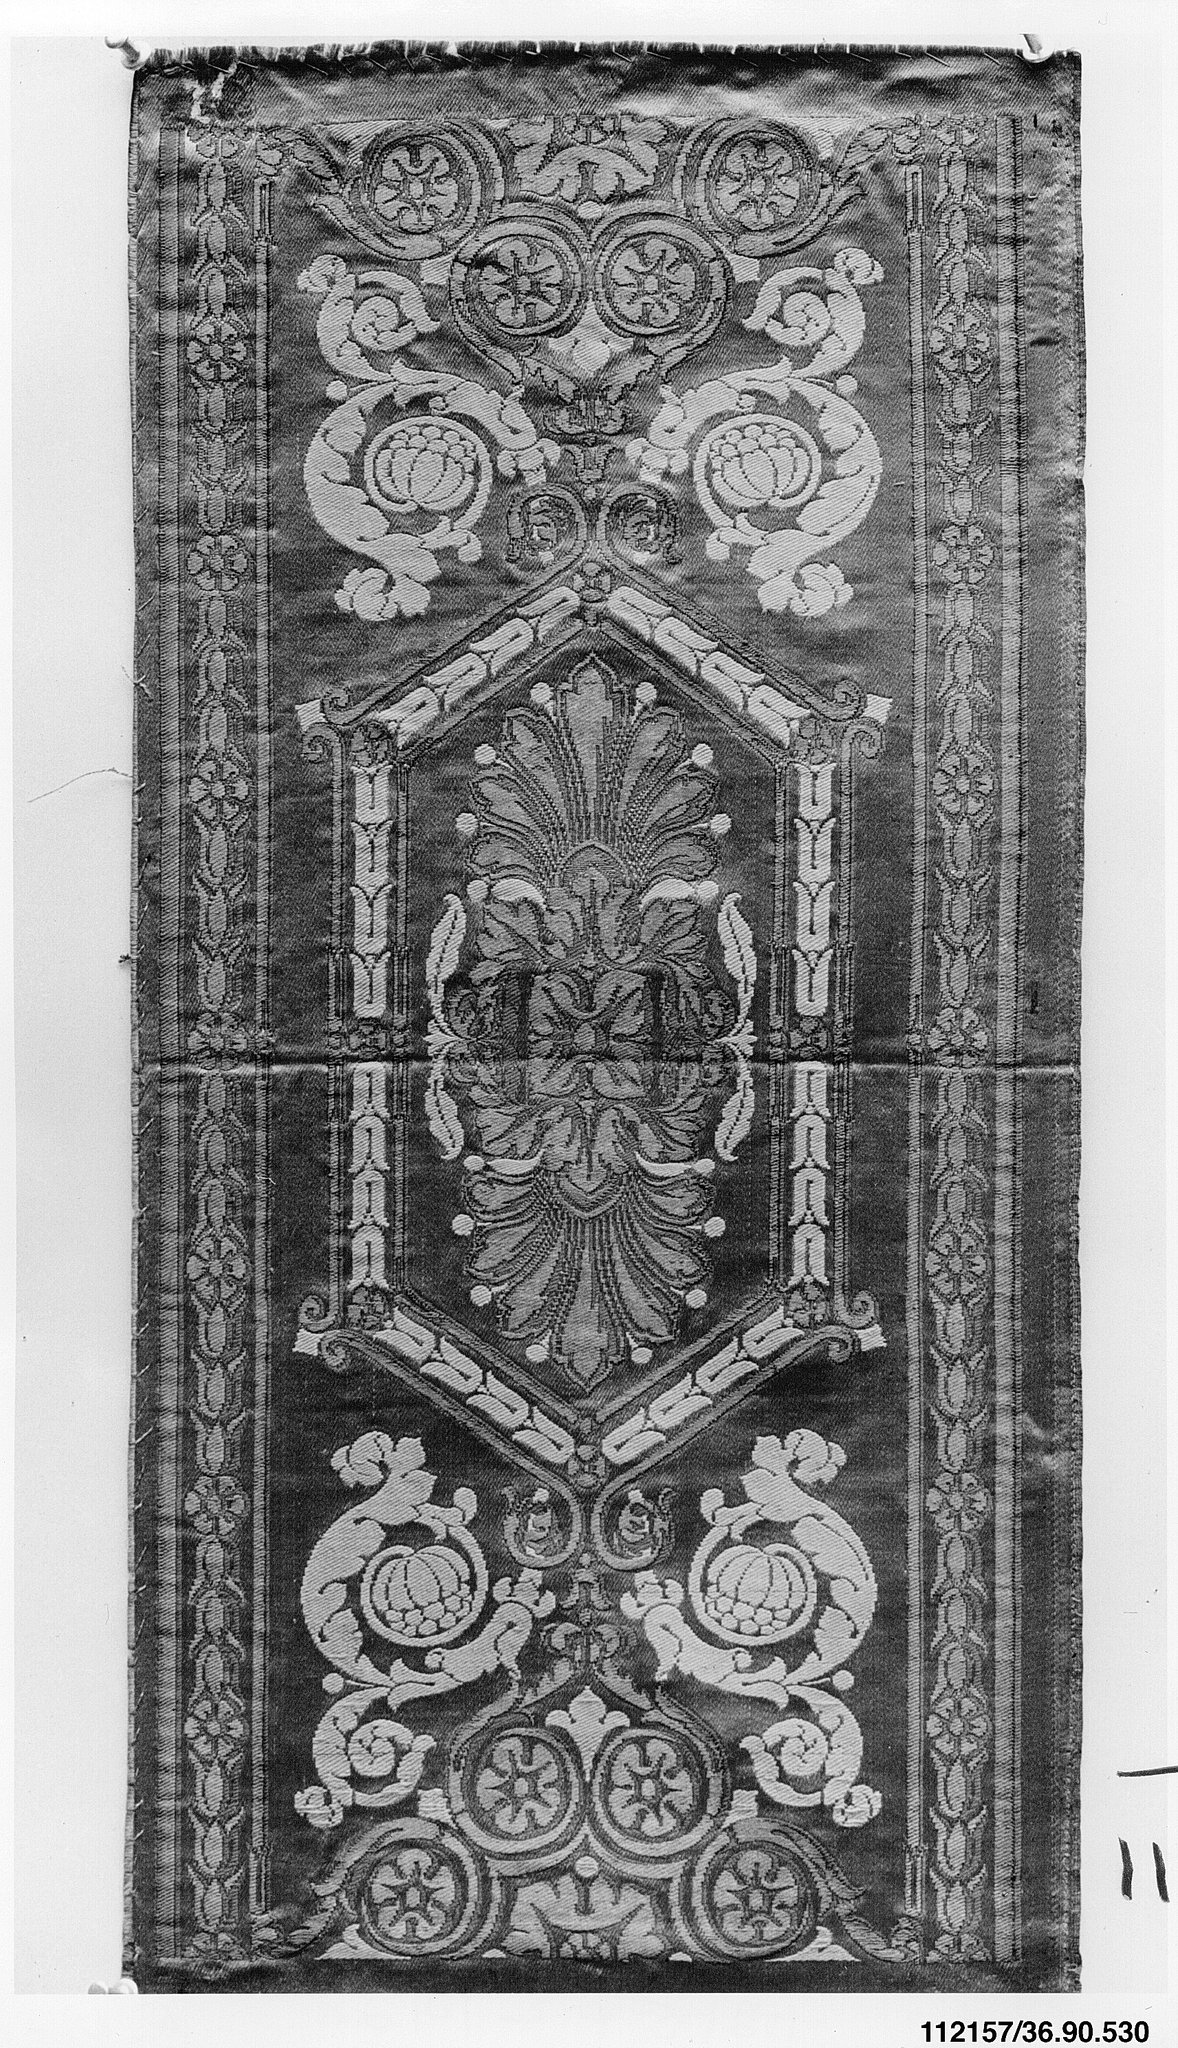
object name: piece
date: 1805-1815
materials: metal thread, silk